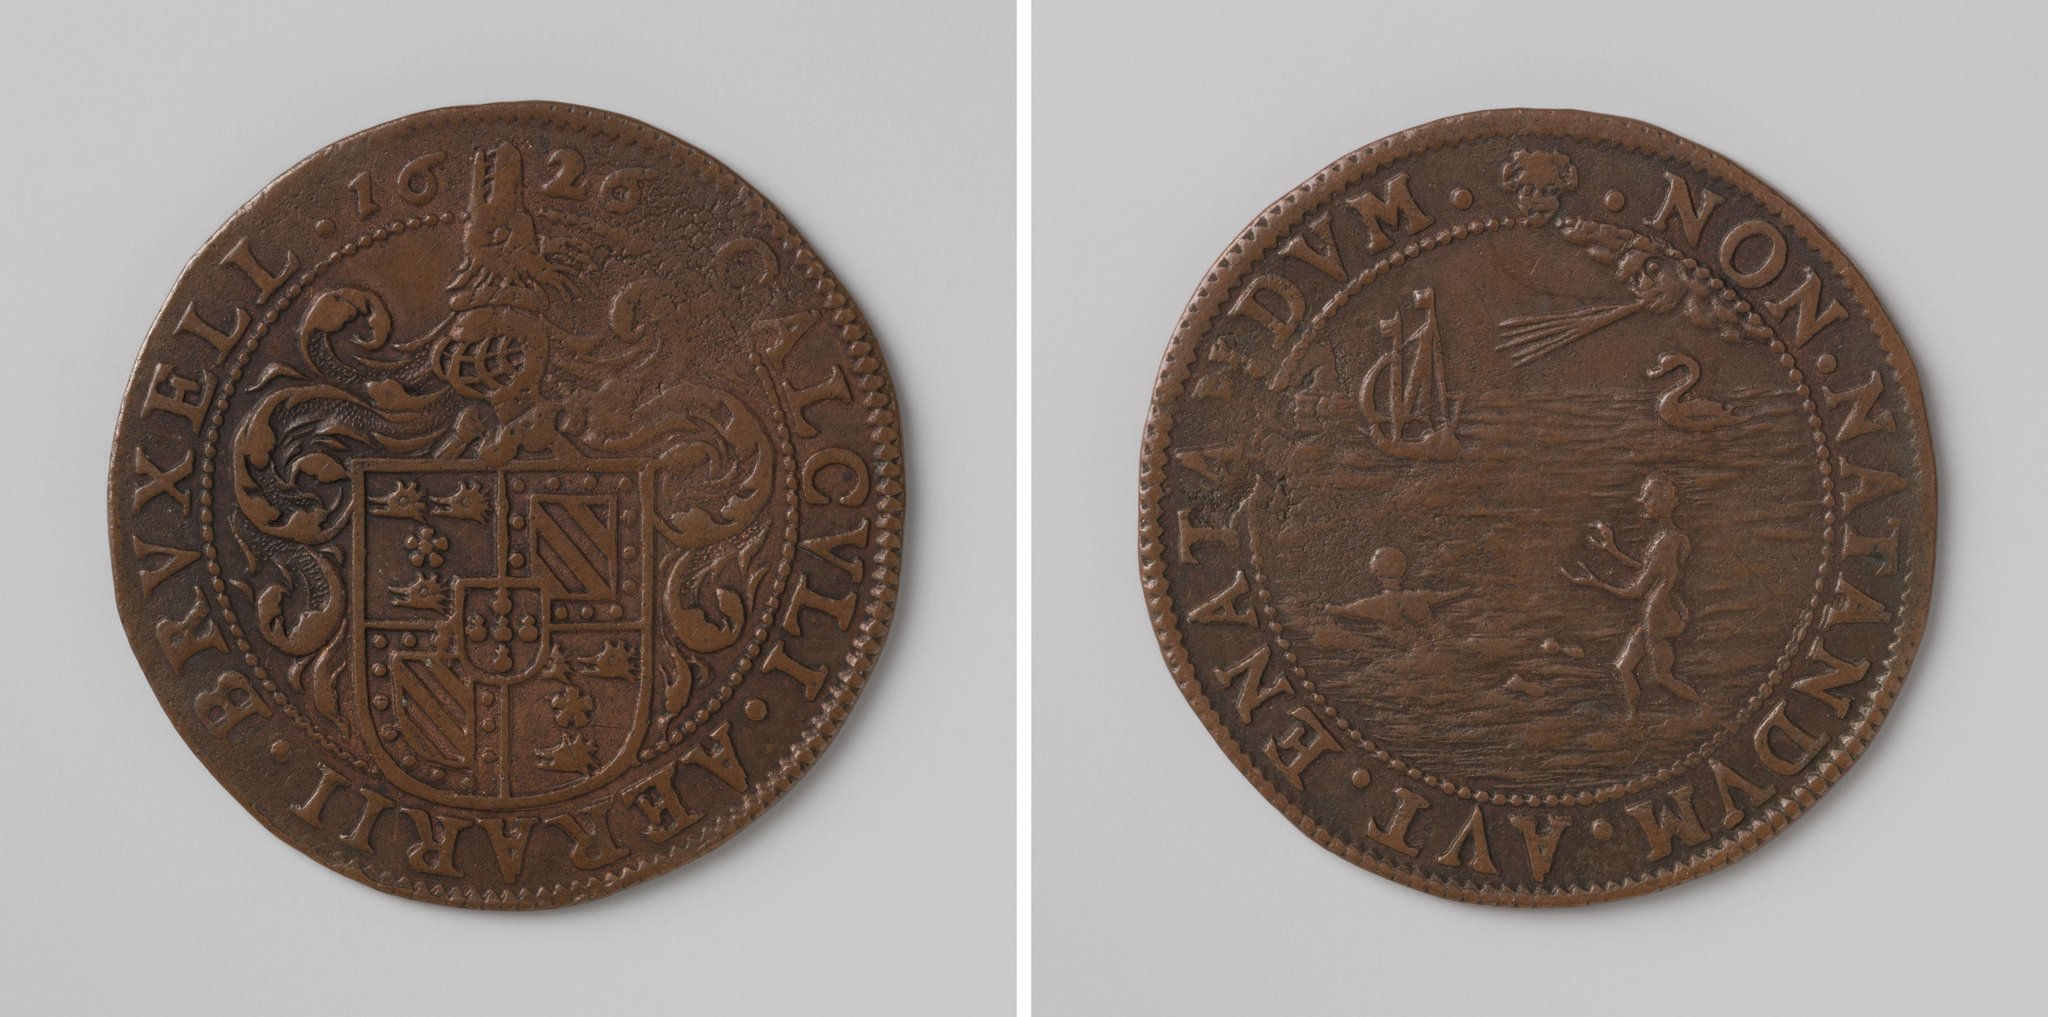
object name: jeton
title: J. B. Schotte, magistraat van de schatkist van Brussel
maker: Anonymous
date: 1601-1626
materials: copper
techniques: striking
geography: brussels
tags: brussels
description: Koperen penning. Voorzijde: gehelmd wapenschild binnen omschrift. Keerzijde: twee zwemmende, naakte mannen; op achtergrond schip, zwaan en stormwind binnen omschrift